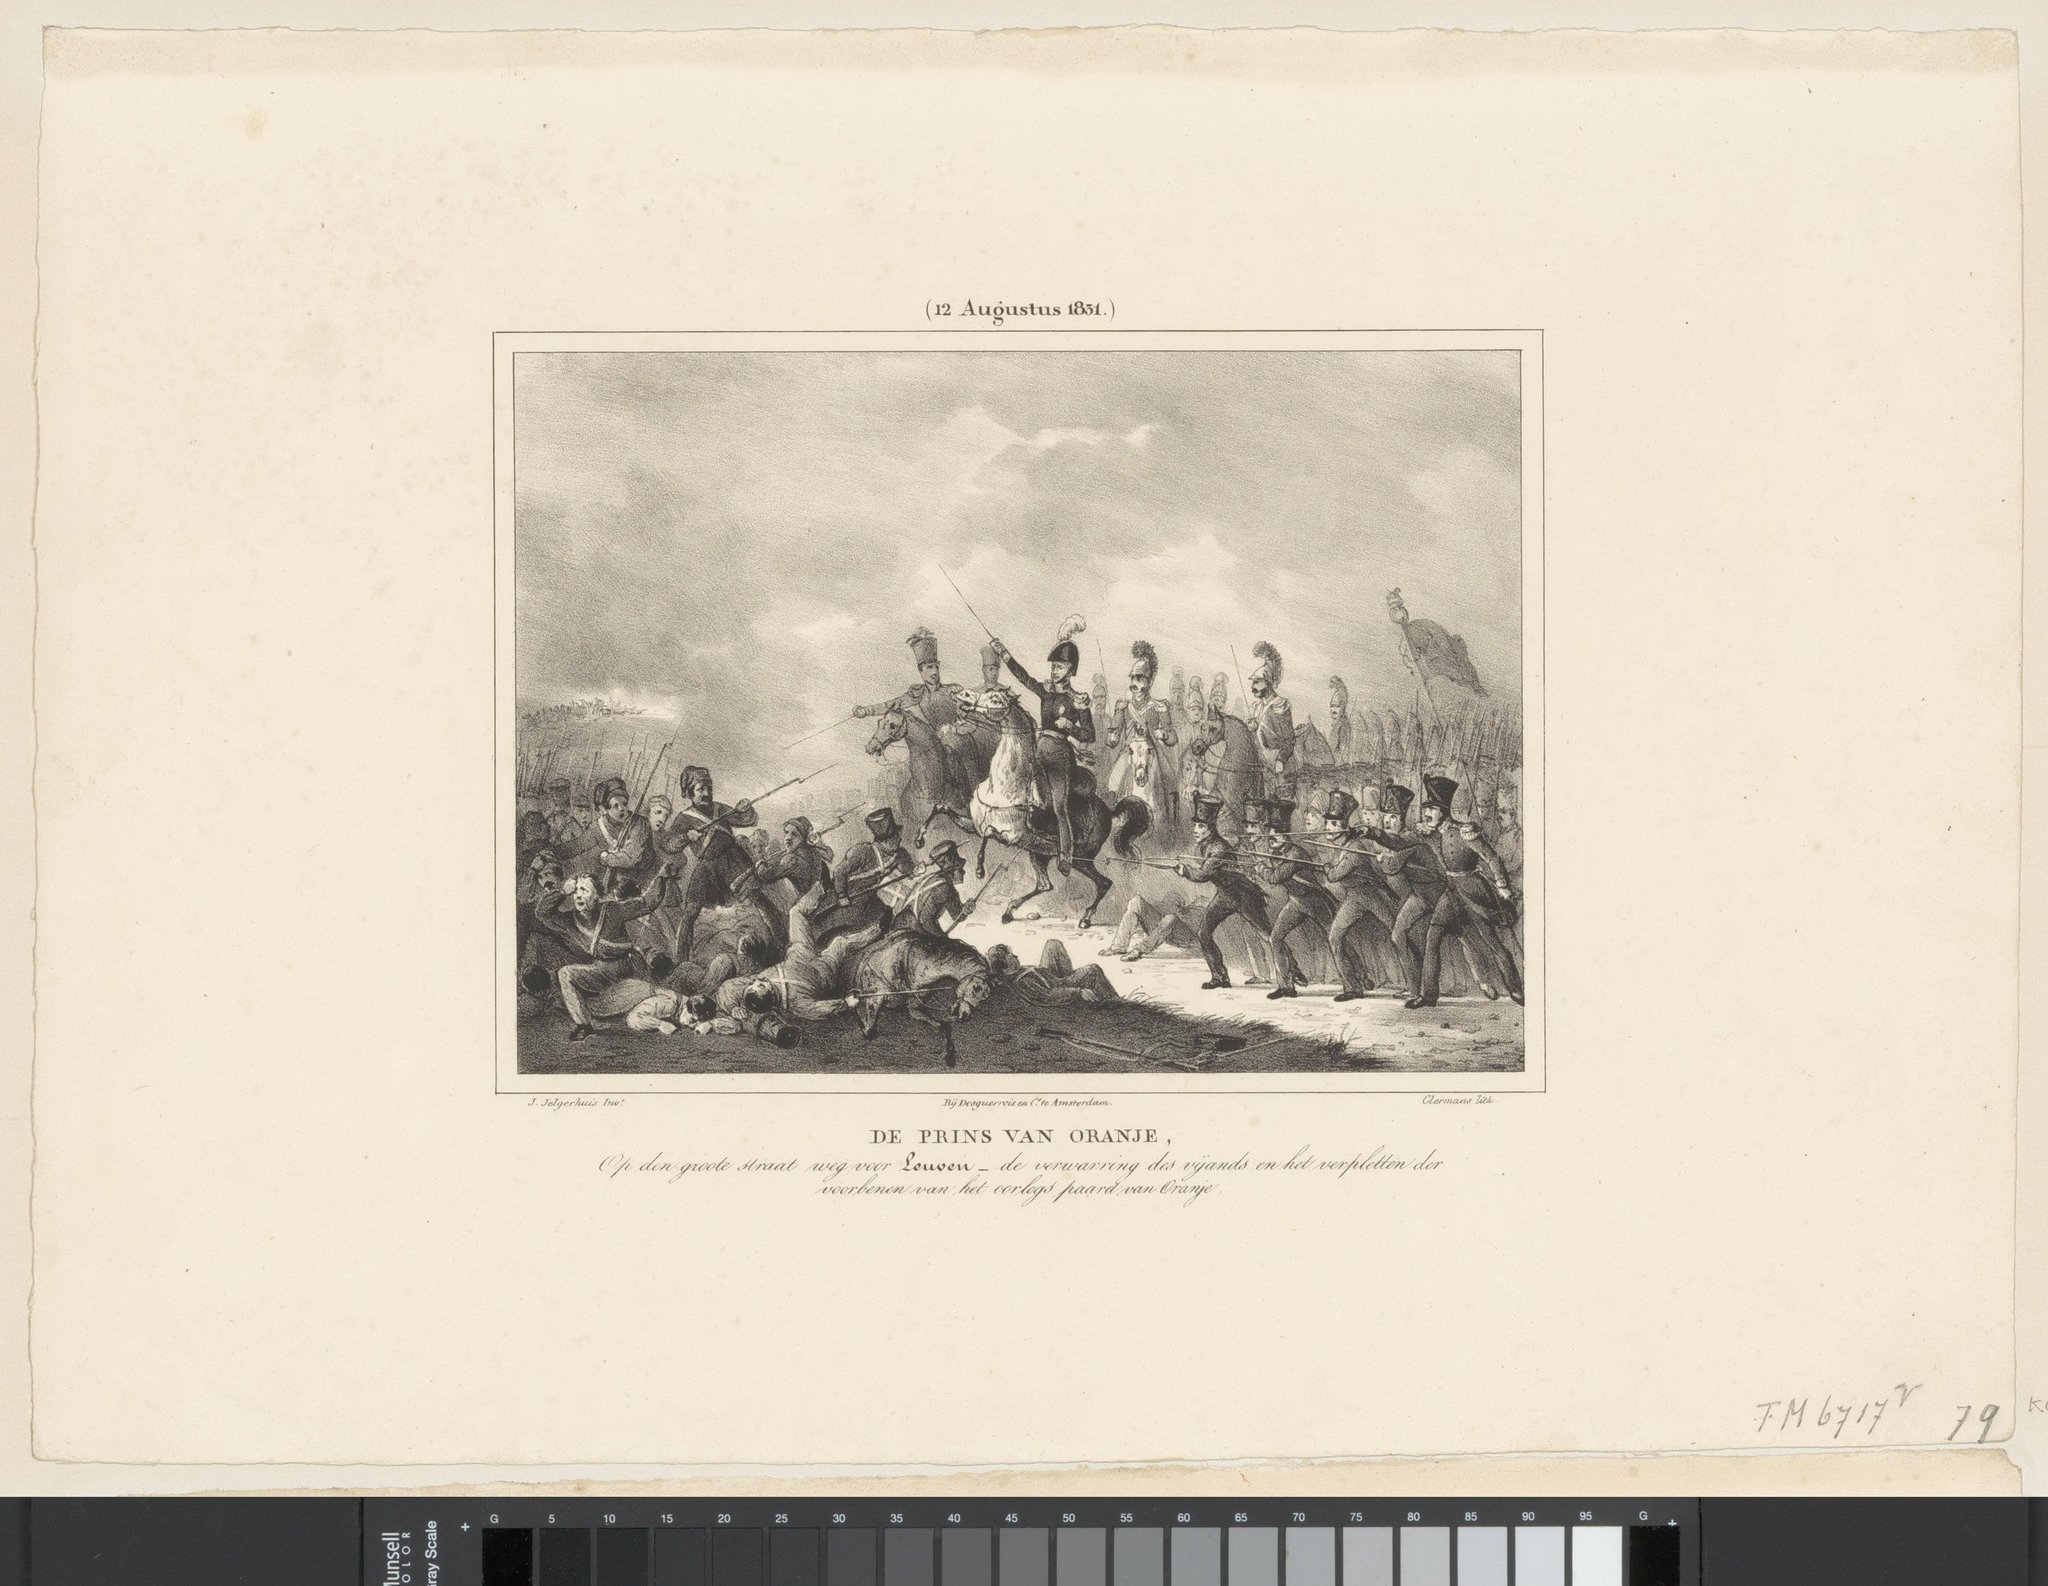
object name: print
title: Slag bij Leuven, 1831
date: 1831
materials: paper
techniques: lithograph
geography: netherlands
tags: the hague, william ii of the netherlands, fighting horses, battle (+ land forces), louvain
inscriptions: collector's mark: Lugt 1641, collector's mark